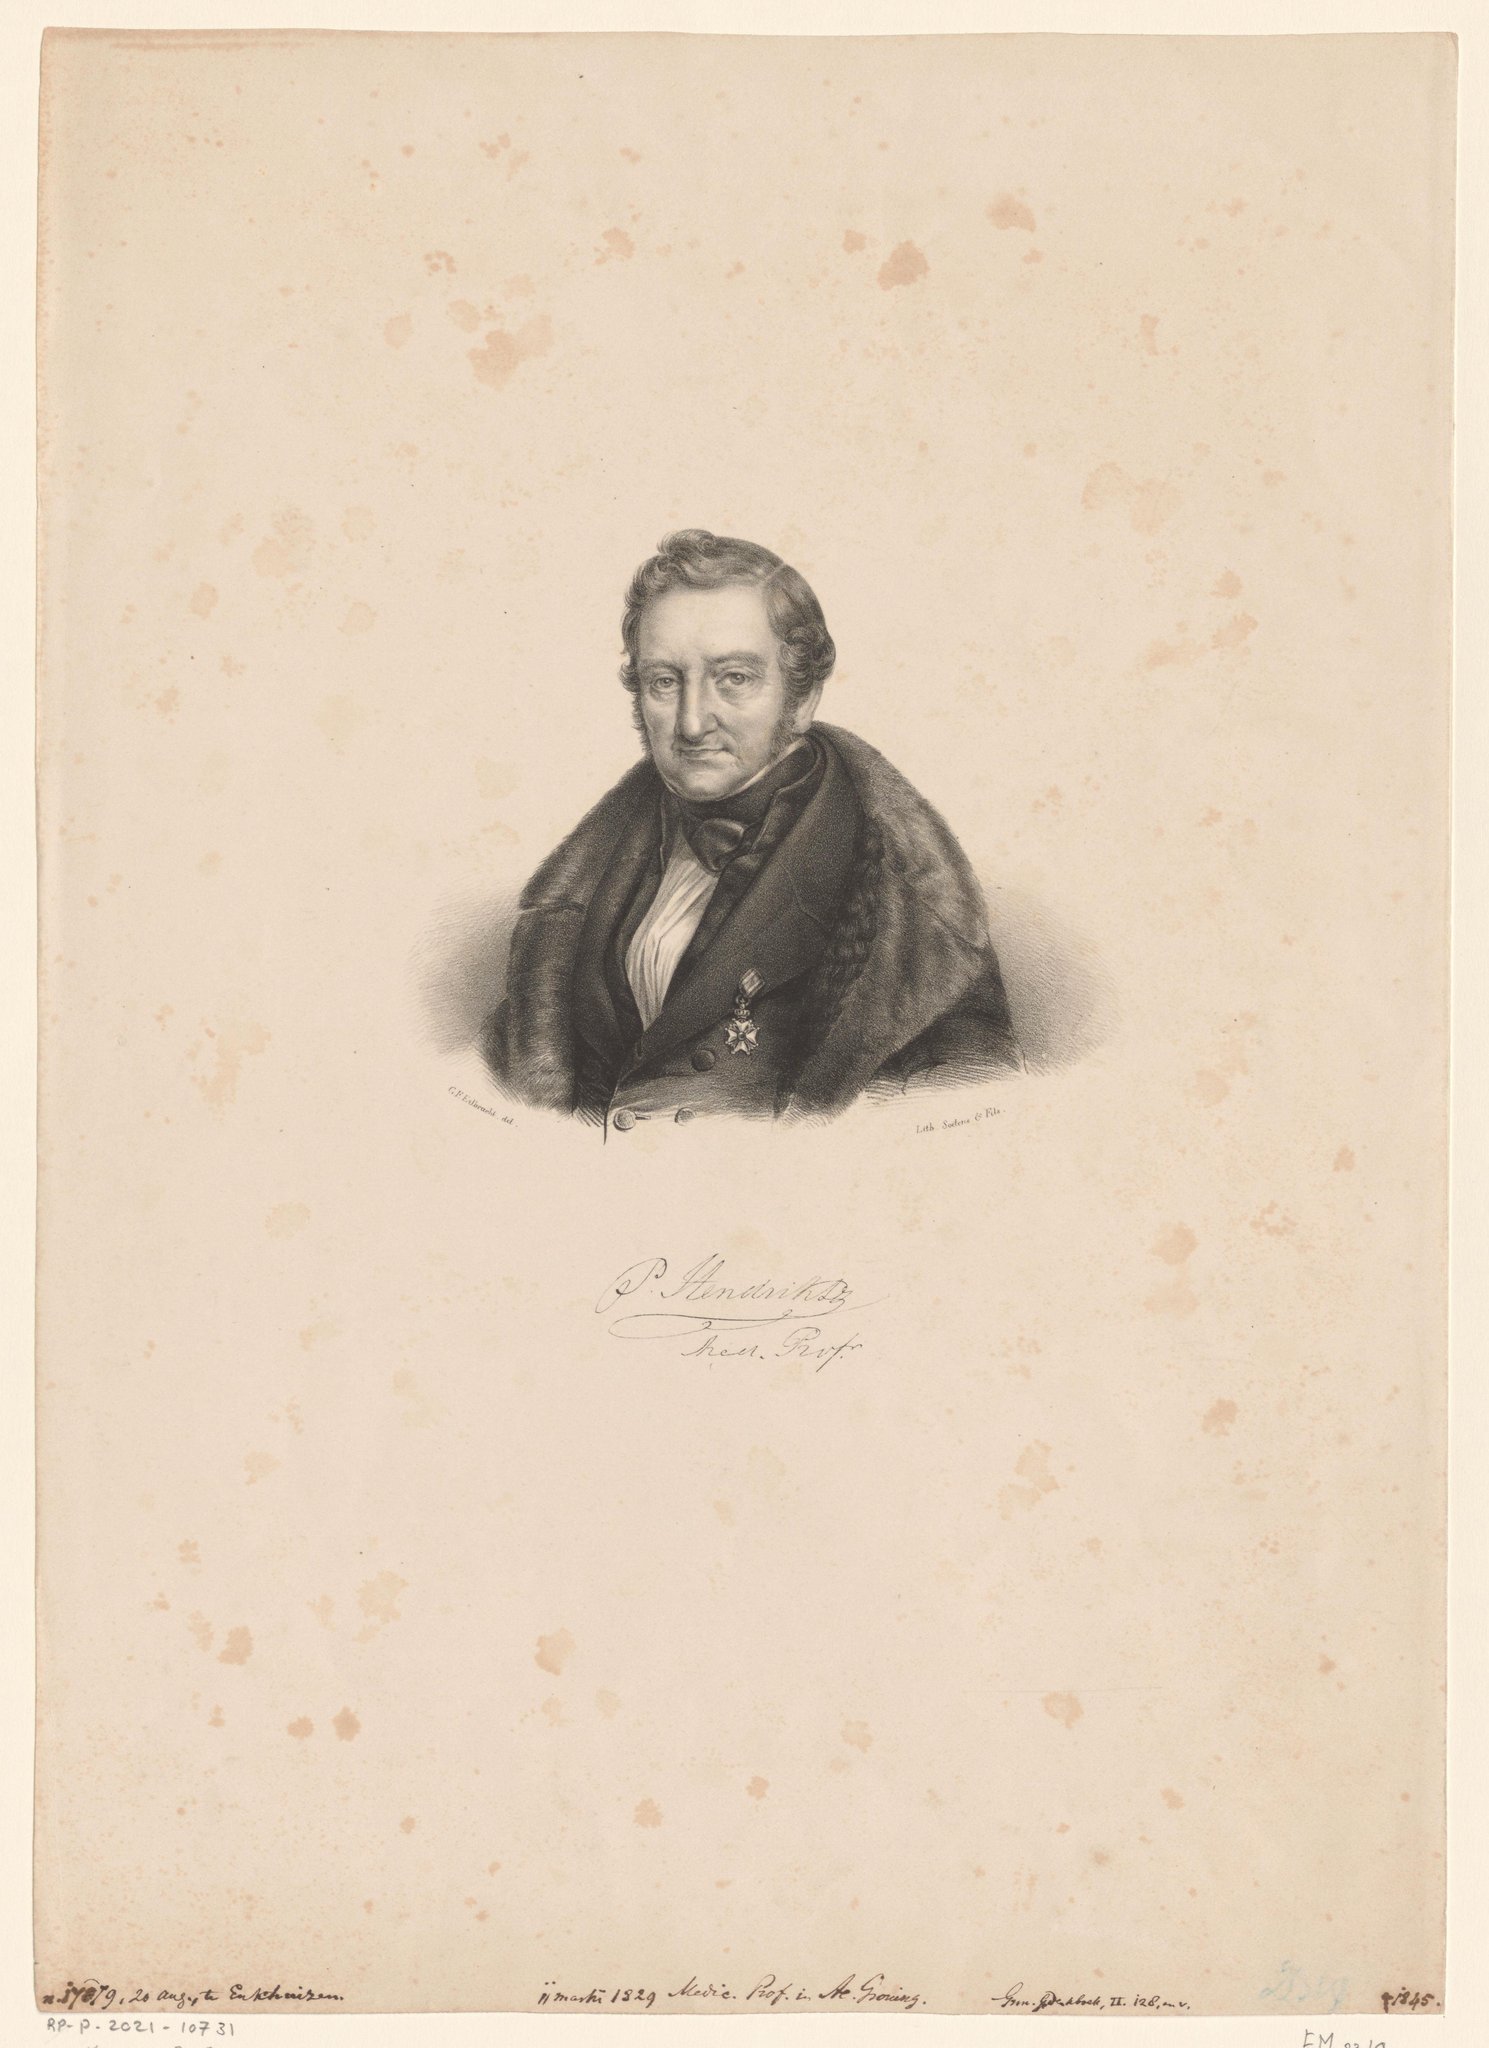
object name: print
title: Portret van Pieter Hendriksz.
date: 1837-1840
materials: paper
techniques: lithograph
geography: the hague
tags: enkhuizen, voorburg, historical persons, physician, doctor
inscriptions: collector's mark: Lugt 2228, inscription: ‘n 1787, 20 aug., te Enkhuizen (...)’